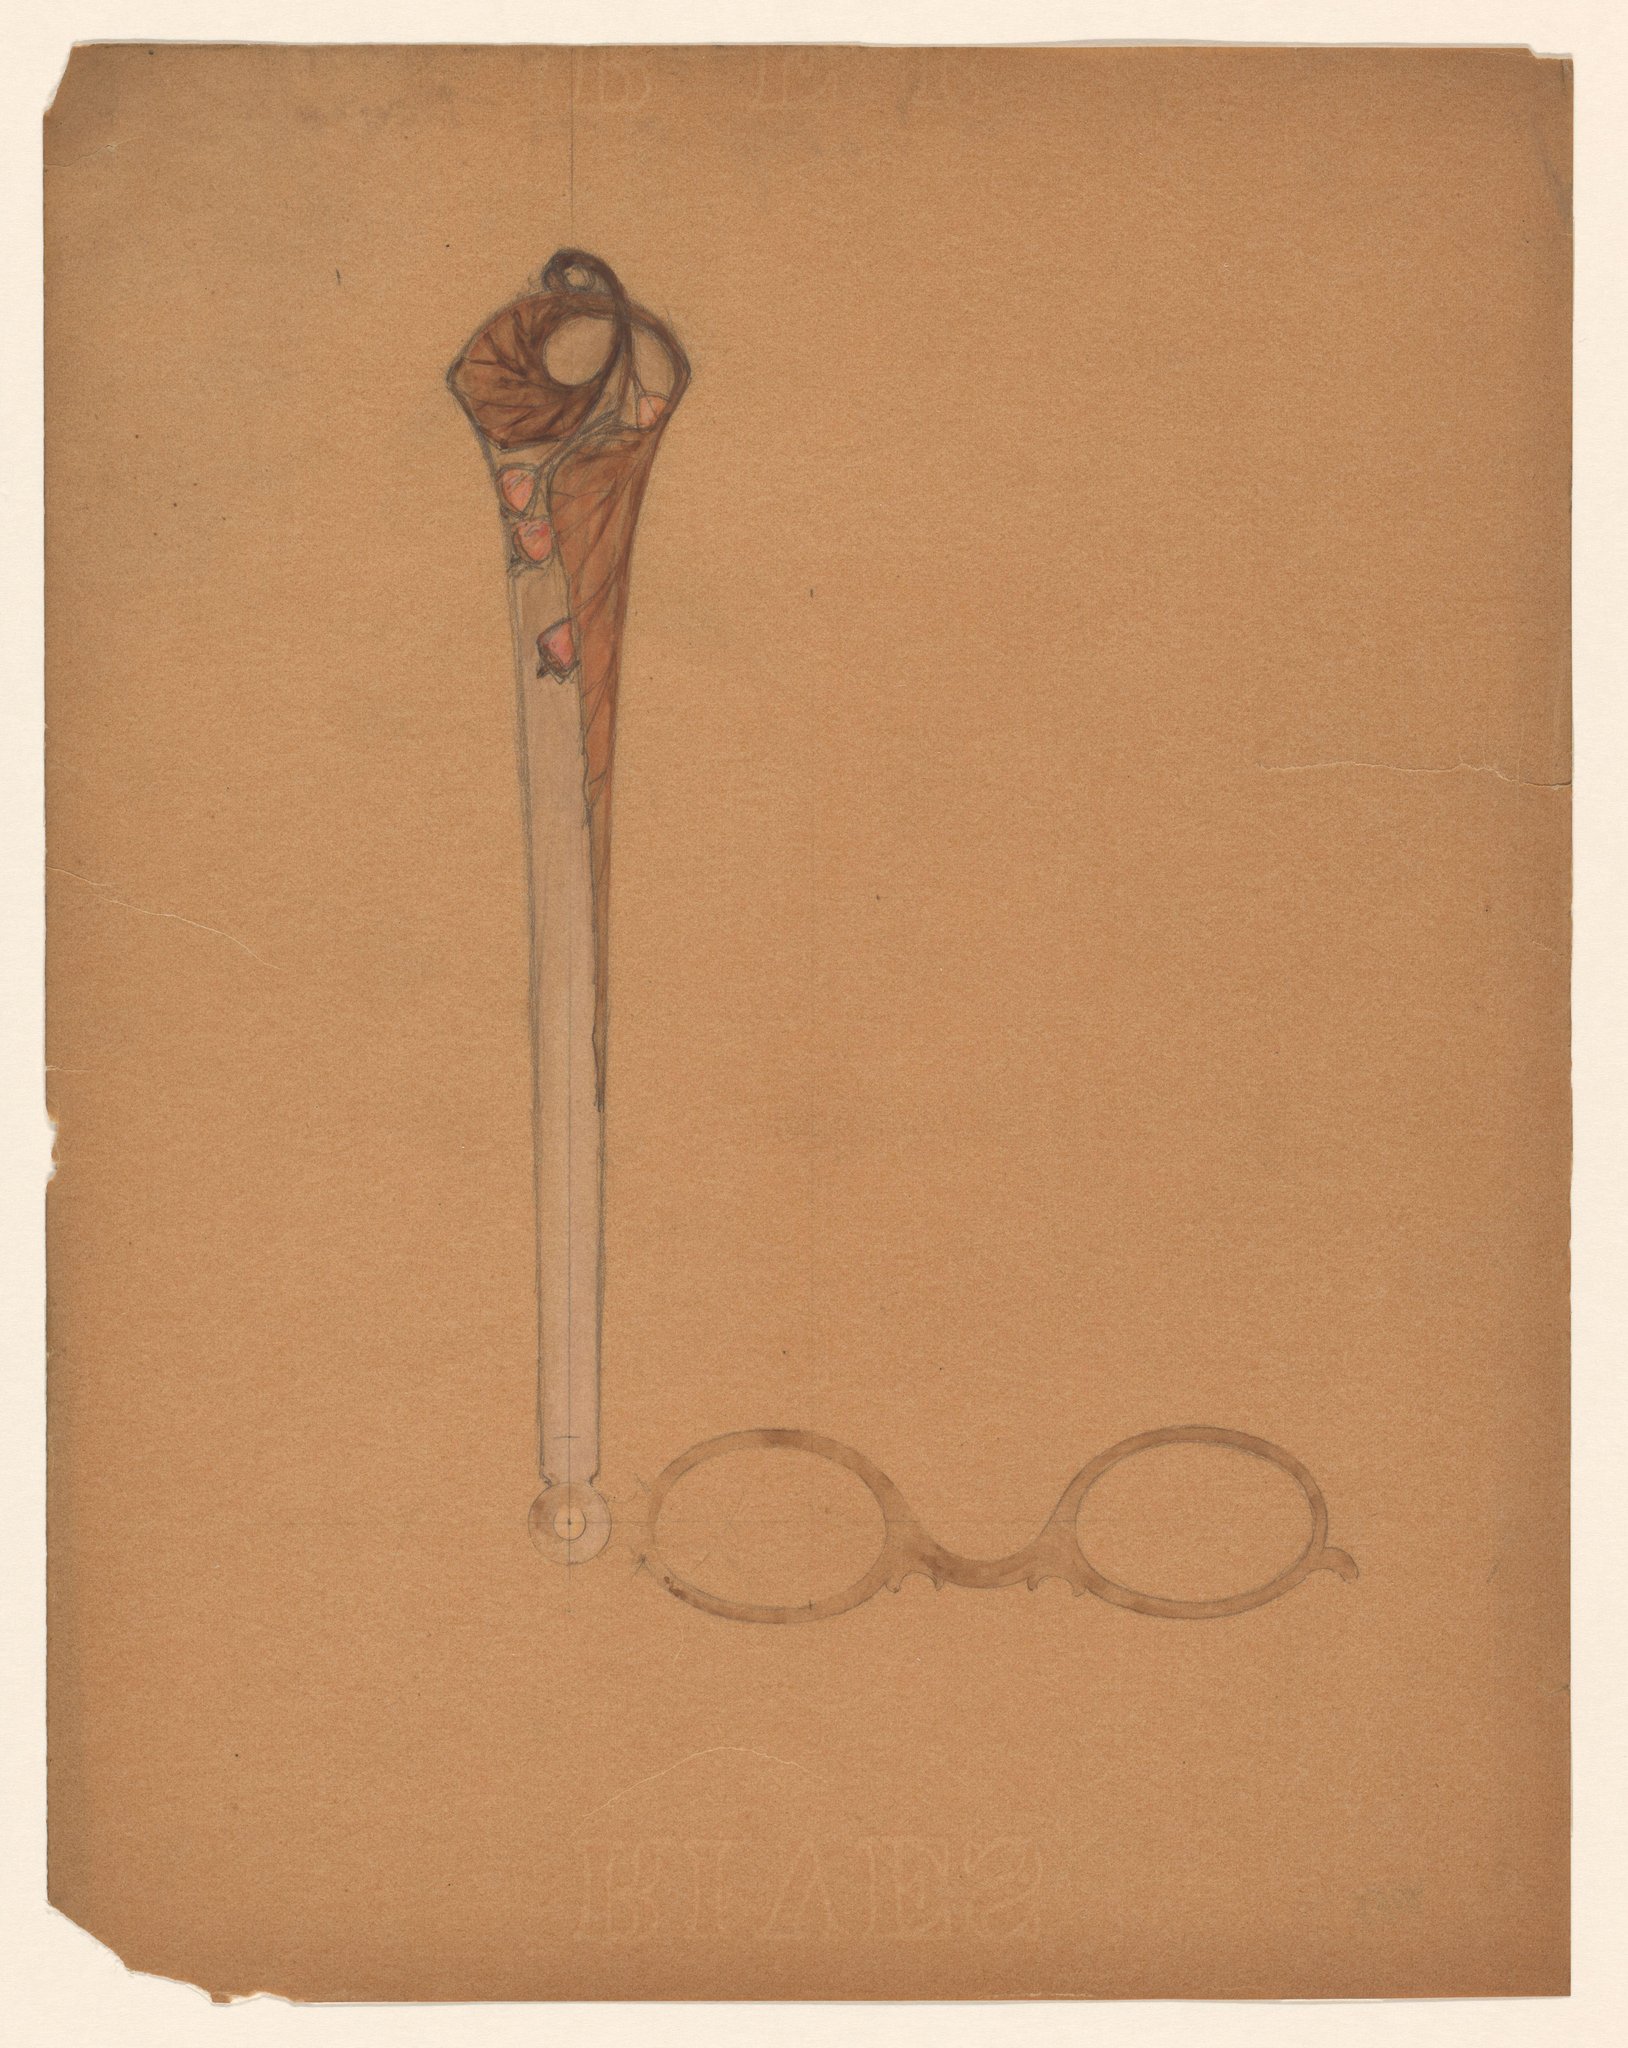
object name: design drawing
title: Design for a Lorgnette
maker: rené lalique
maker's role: jeweler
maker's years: 1860-1945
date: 1900-1904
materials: chalk, graphite, paper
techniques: aquarelle, brush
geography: france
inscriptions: watermark: ‘BFK / RIVES’, number: ‘4055 [?]’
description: In this design for a lorgnette made of horn Lalique has exploited the different colours present in the material, causing the leaves to stand out in dark relief. The red flowers would probably be enamelled. Lalique’s jewels were eagerly collected by his contemporaries, and his design drawings were also sought after.